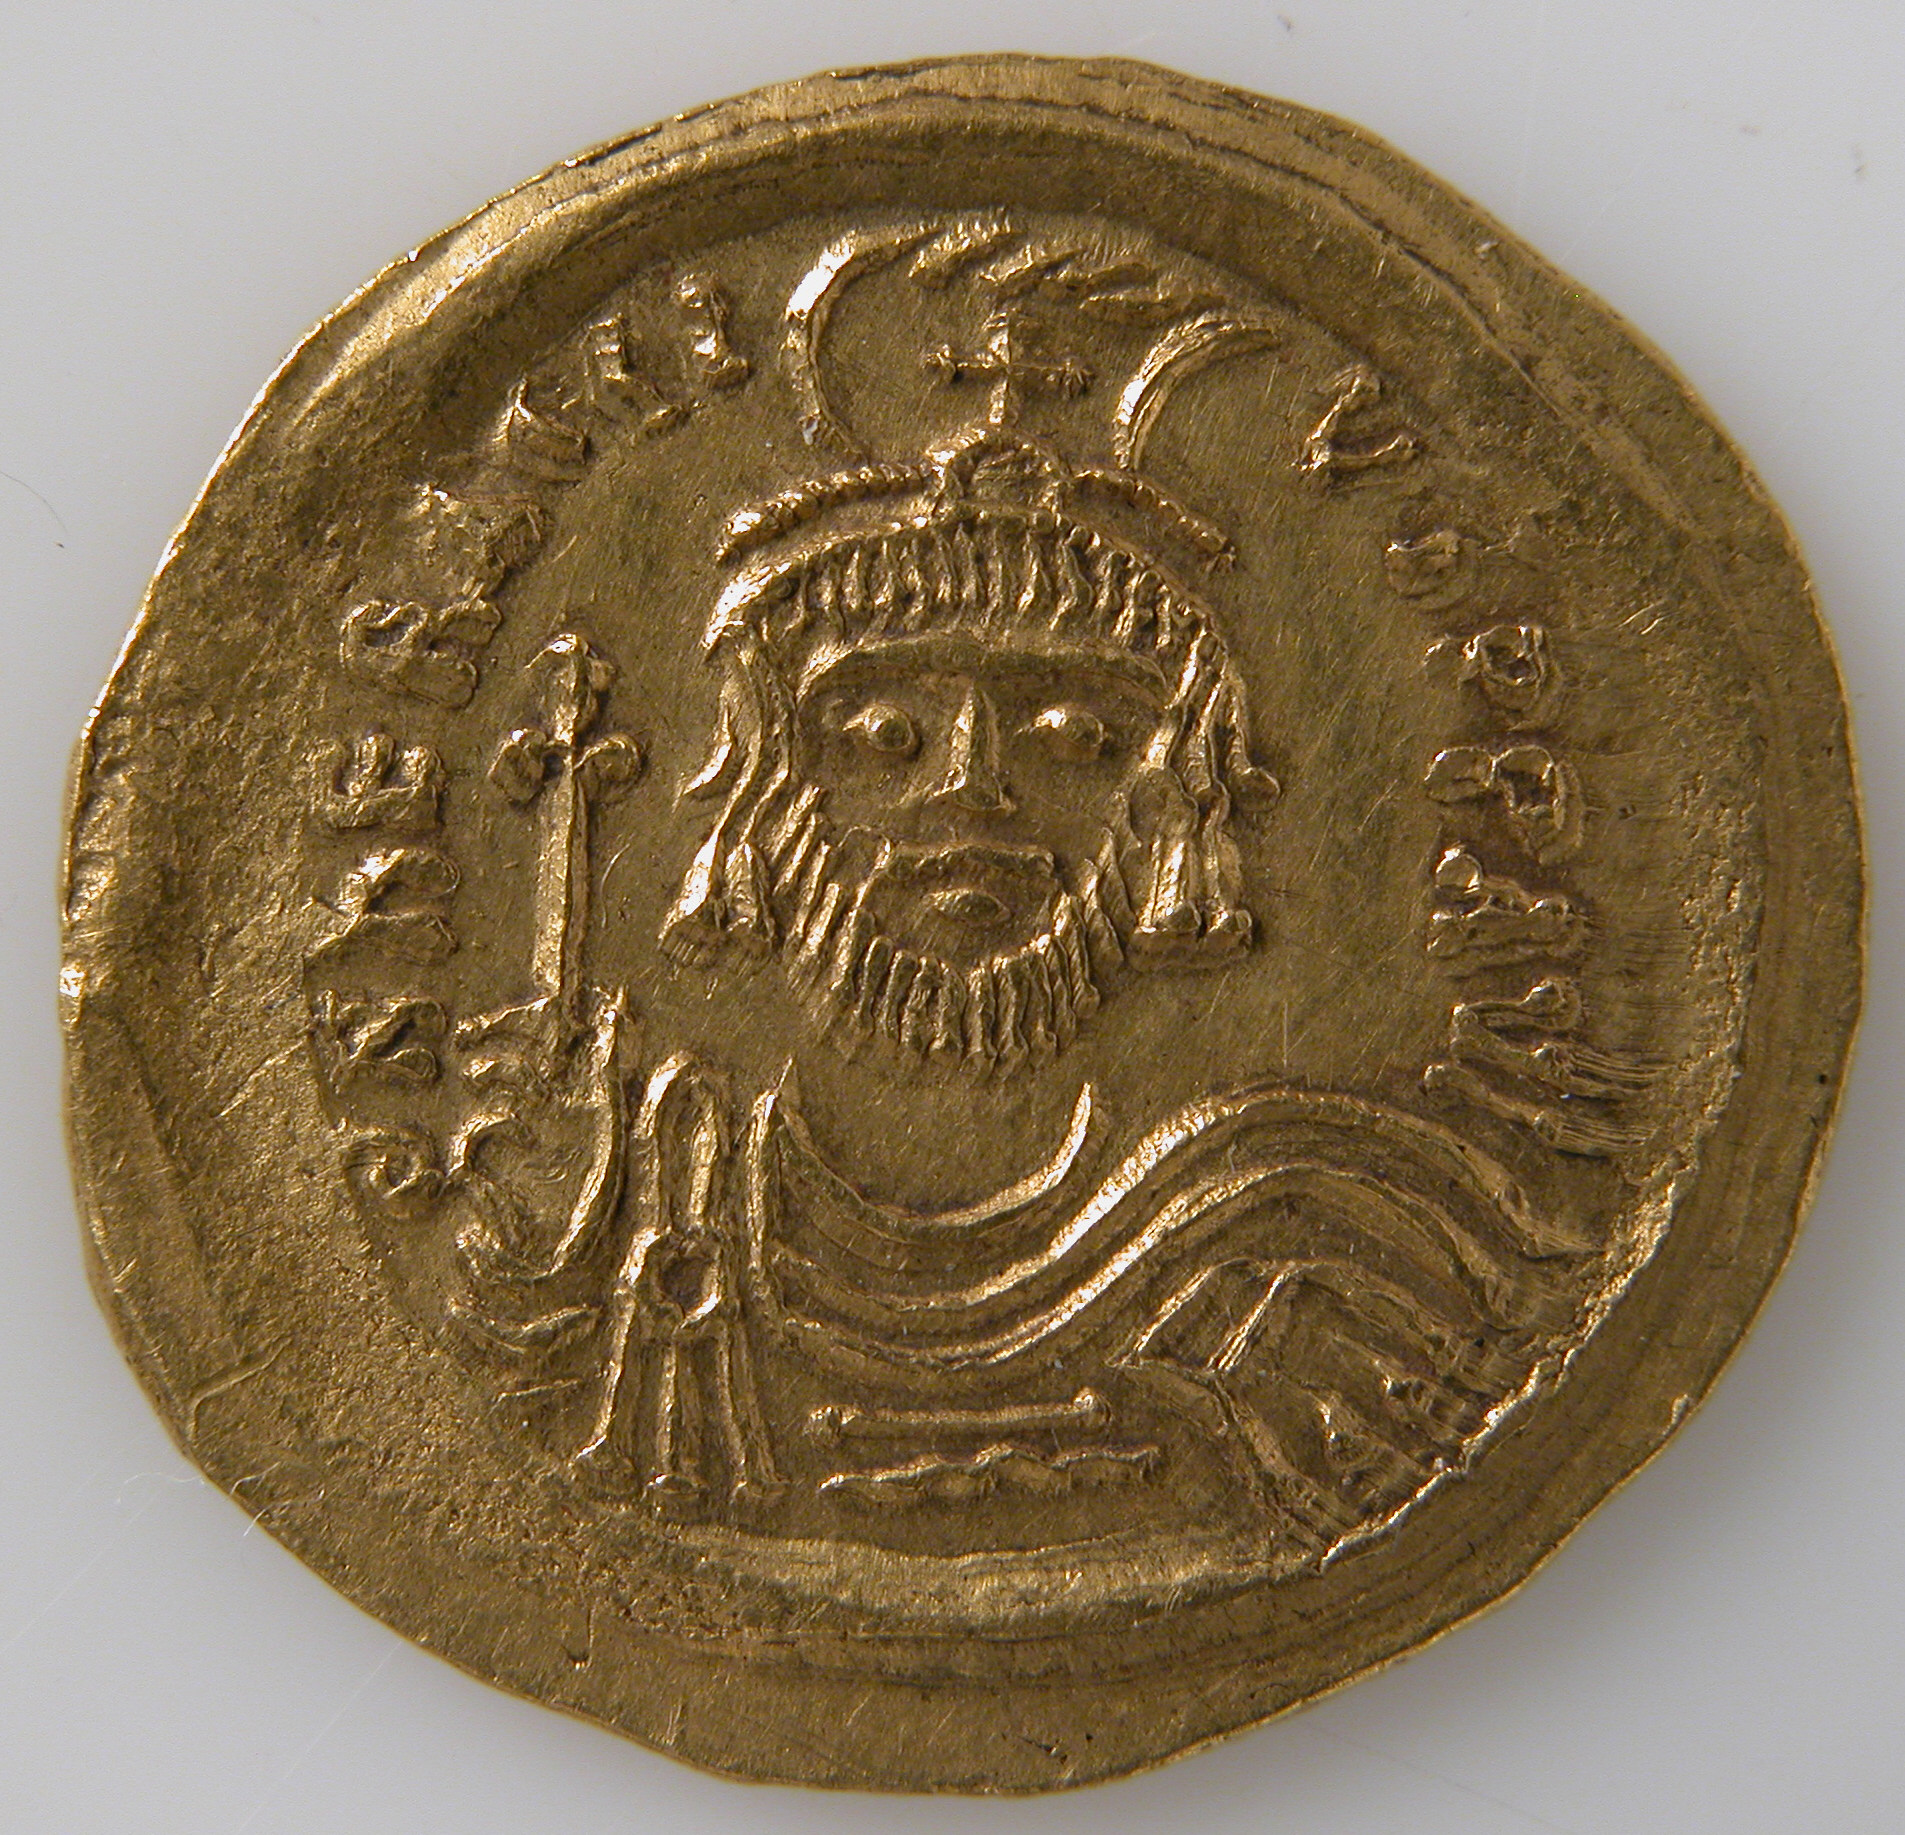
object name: solidus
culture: byzantine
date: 610-641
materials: gold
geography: constantinople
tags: emperors,men